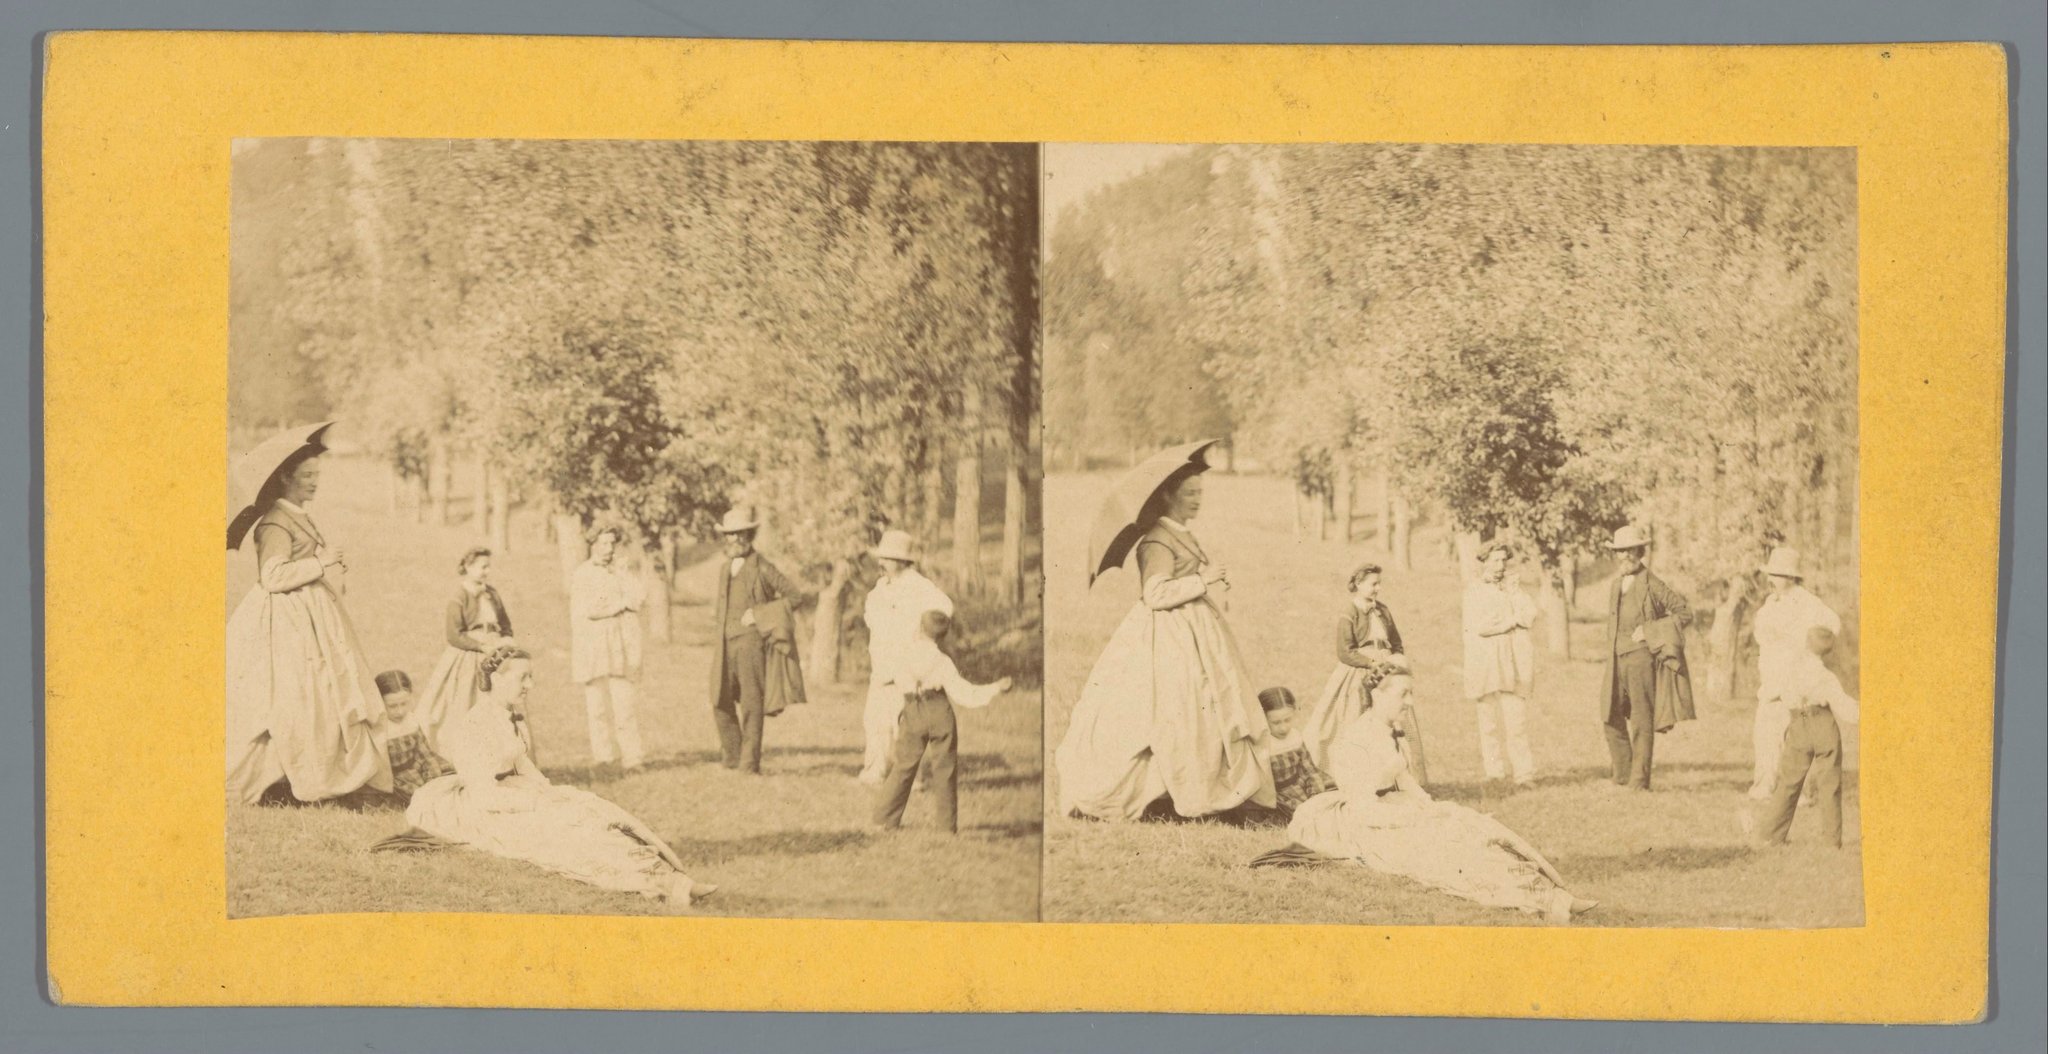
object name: stereograph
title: Gezelschap op een grasveld in een bos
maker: Anonymous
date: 1850-1880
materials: cardboard, photographic support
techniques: albumen print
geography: europe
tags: trees, lawn, parasol, sunshade, europe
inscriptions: number: ‘14460’, inscription: ‘P. 210’